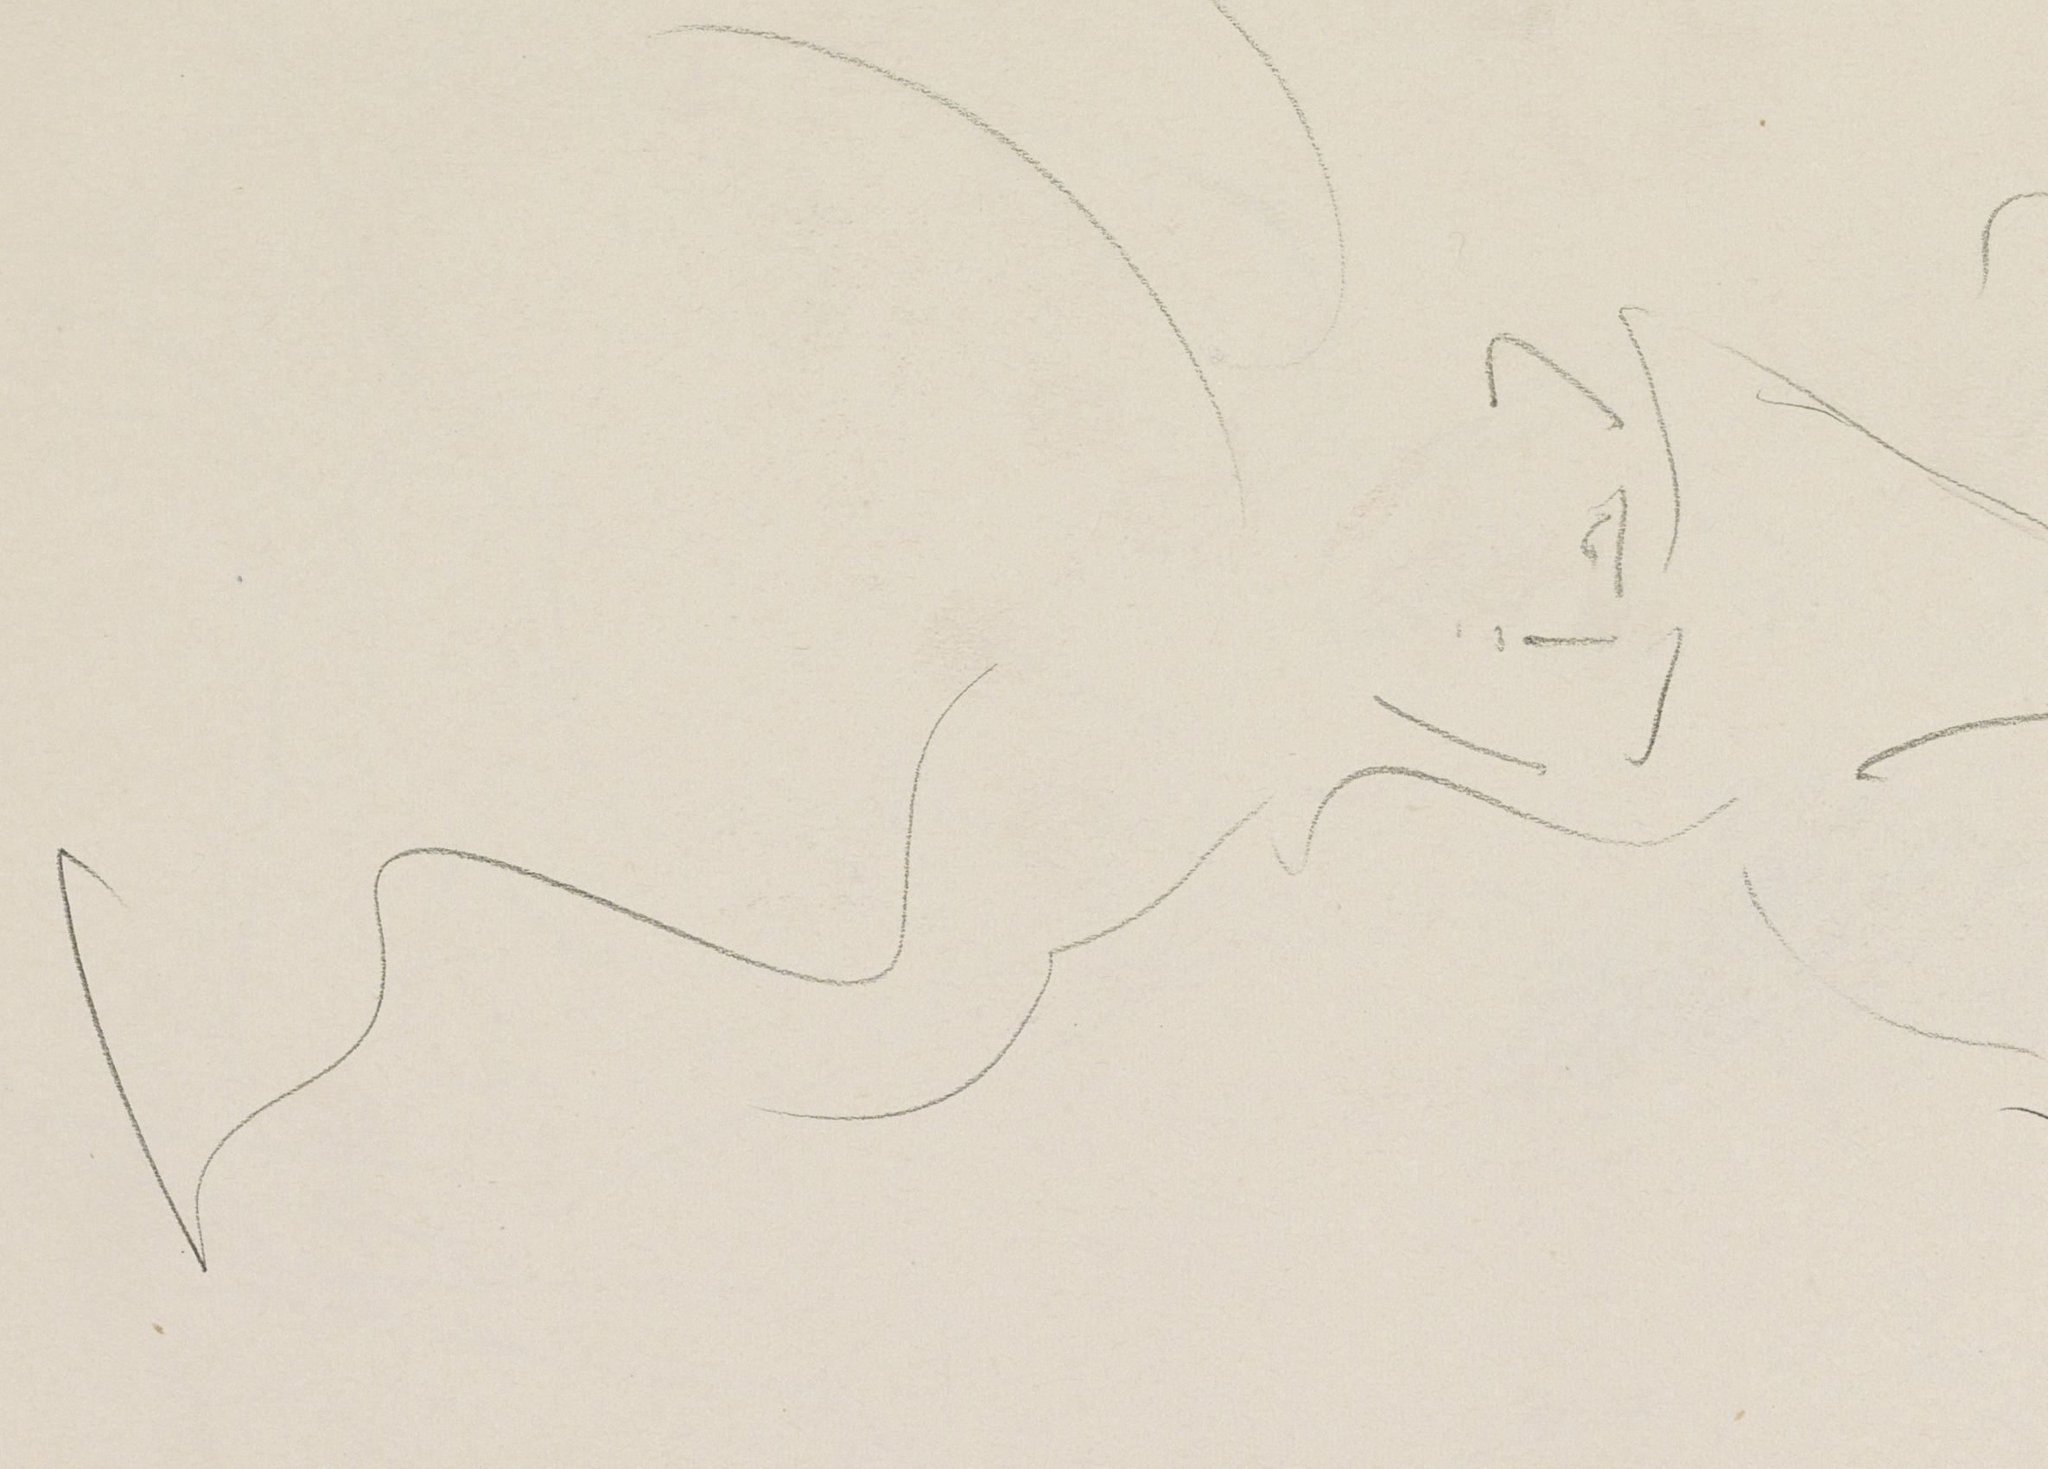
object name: sketchbook leaf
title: Vrouw met een hoofdtooi, mogelijk een revuedanseres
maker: isaac israels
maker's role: draughtsman, painter, print maker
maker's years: 1865-1934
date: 1915-1934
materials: paper, pencil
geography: the hague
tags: female dancer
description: Blad 4 recto uit schetsboek VI met 33 bladen.